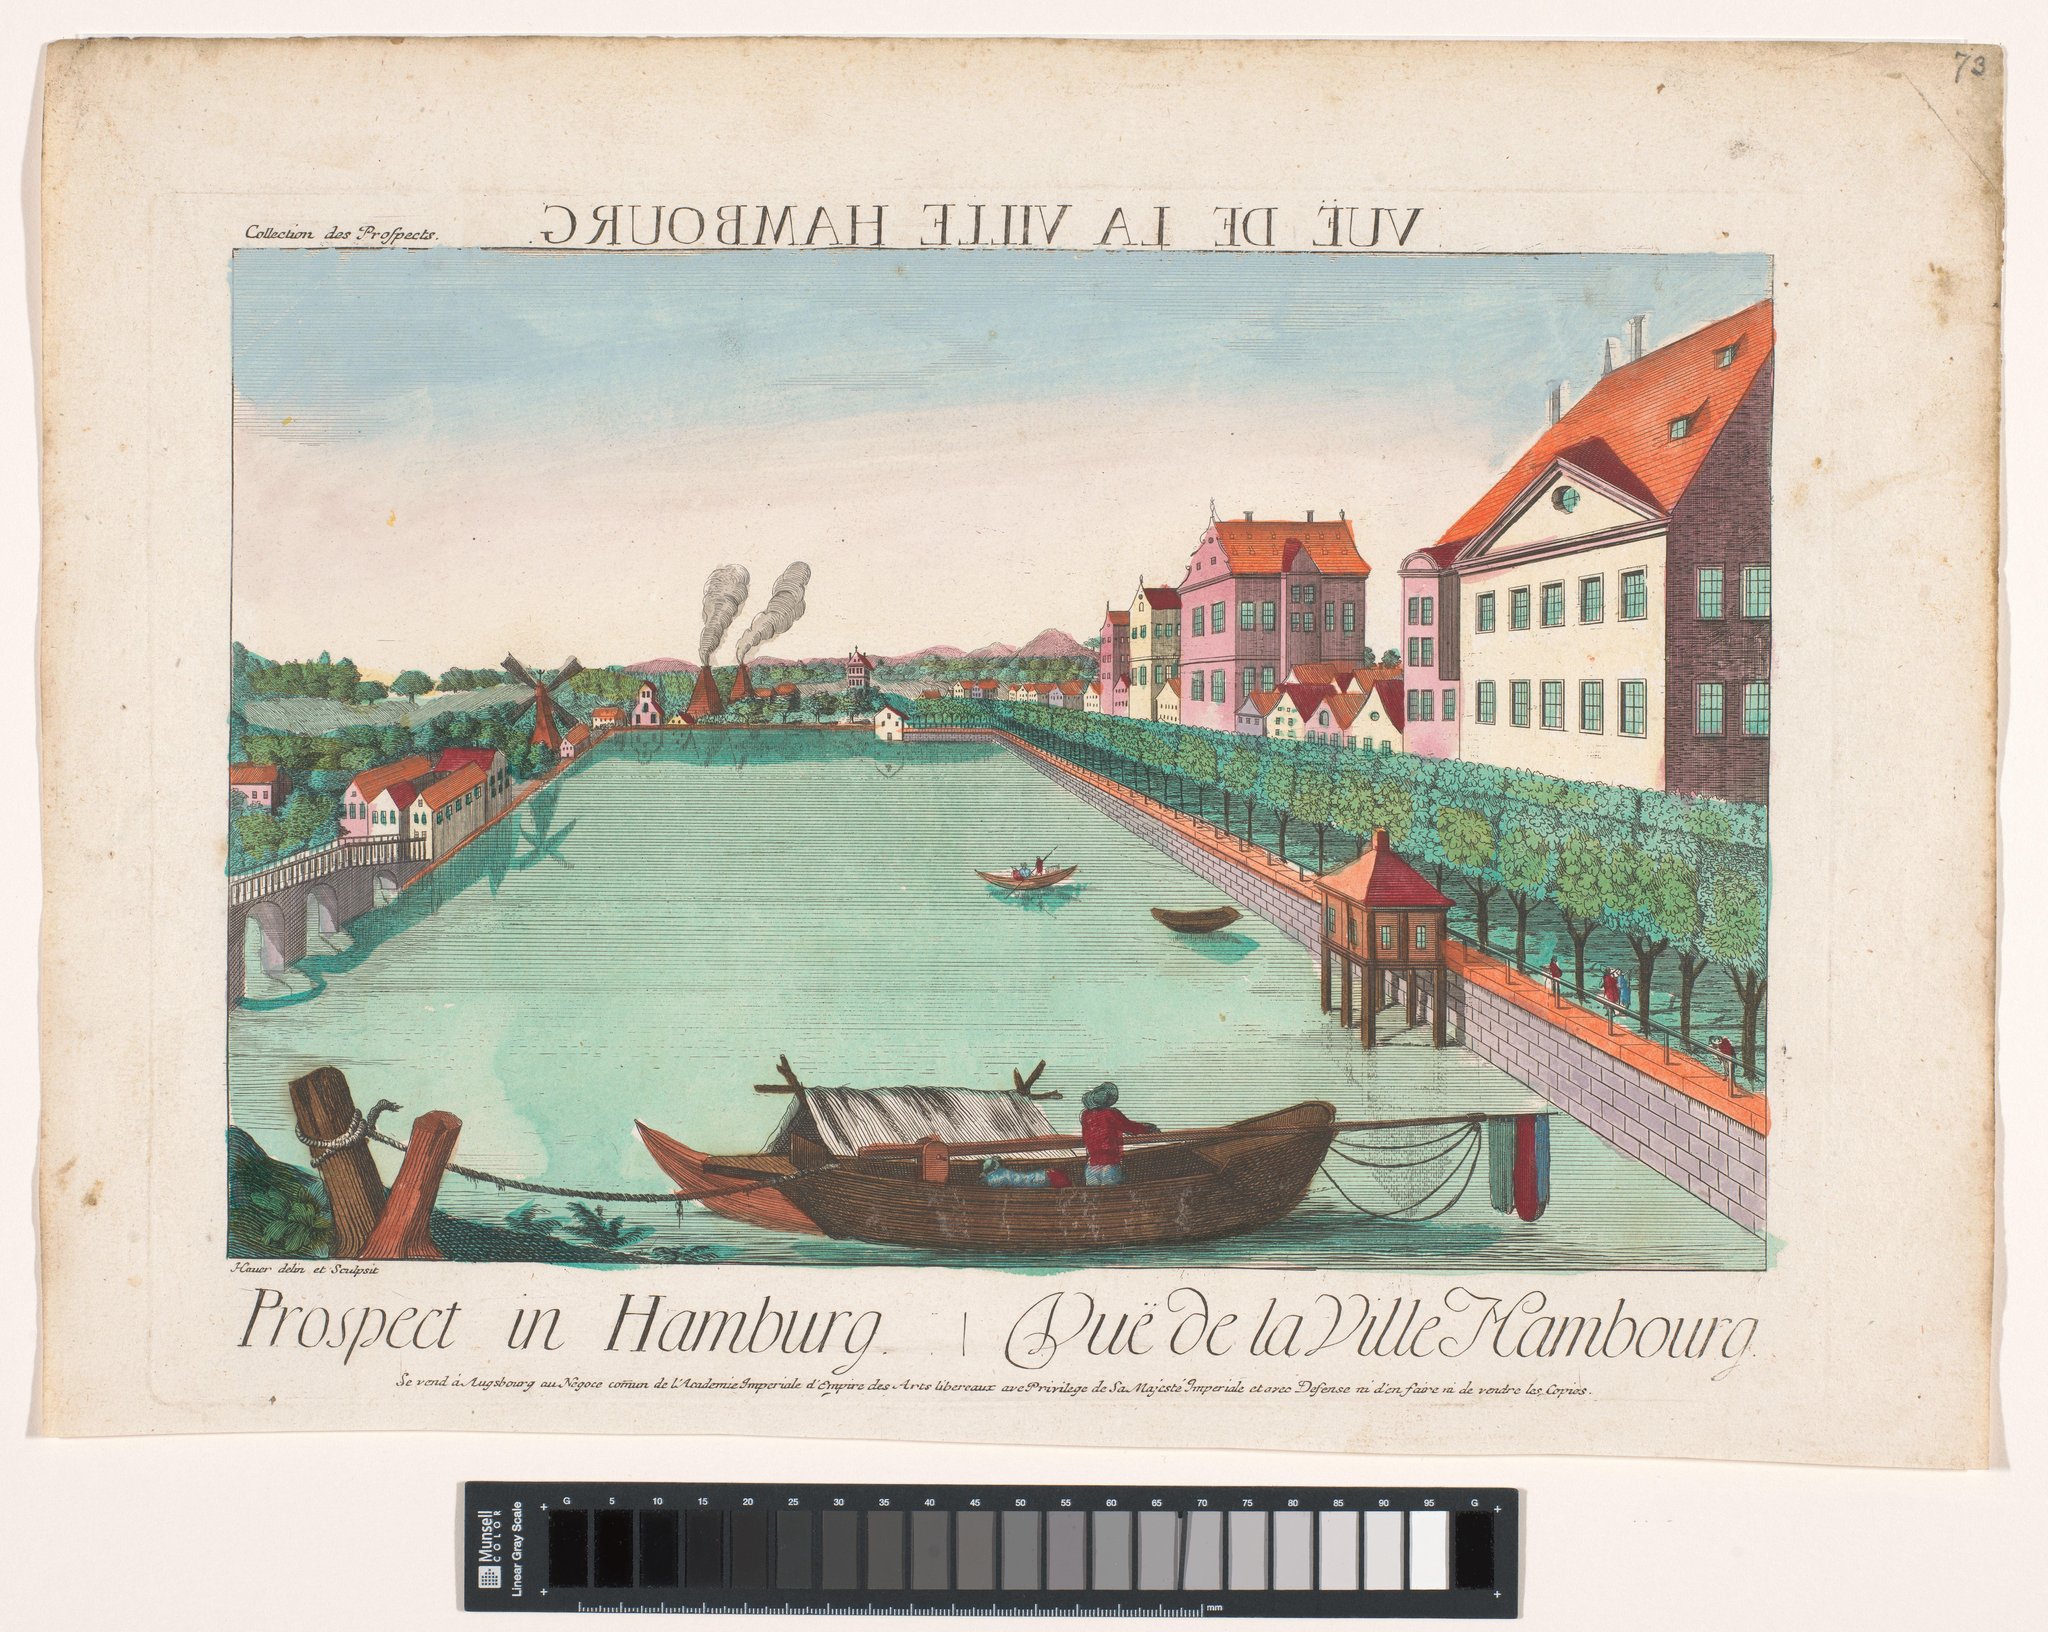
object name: print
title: Prospect in Hamburg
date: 1755-1779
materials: paper, watercolor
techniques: brush, etching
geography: germany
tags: bridge in city across river, canal, etc. (+ city(-scape) with figures, staffage), rowing-boat, canoe, etc., windmill, canals, waters (in city) (+ city(-scape) with figures, staffage)